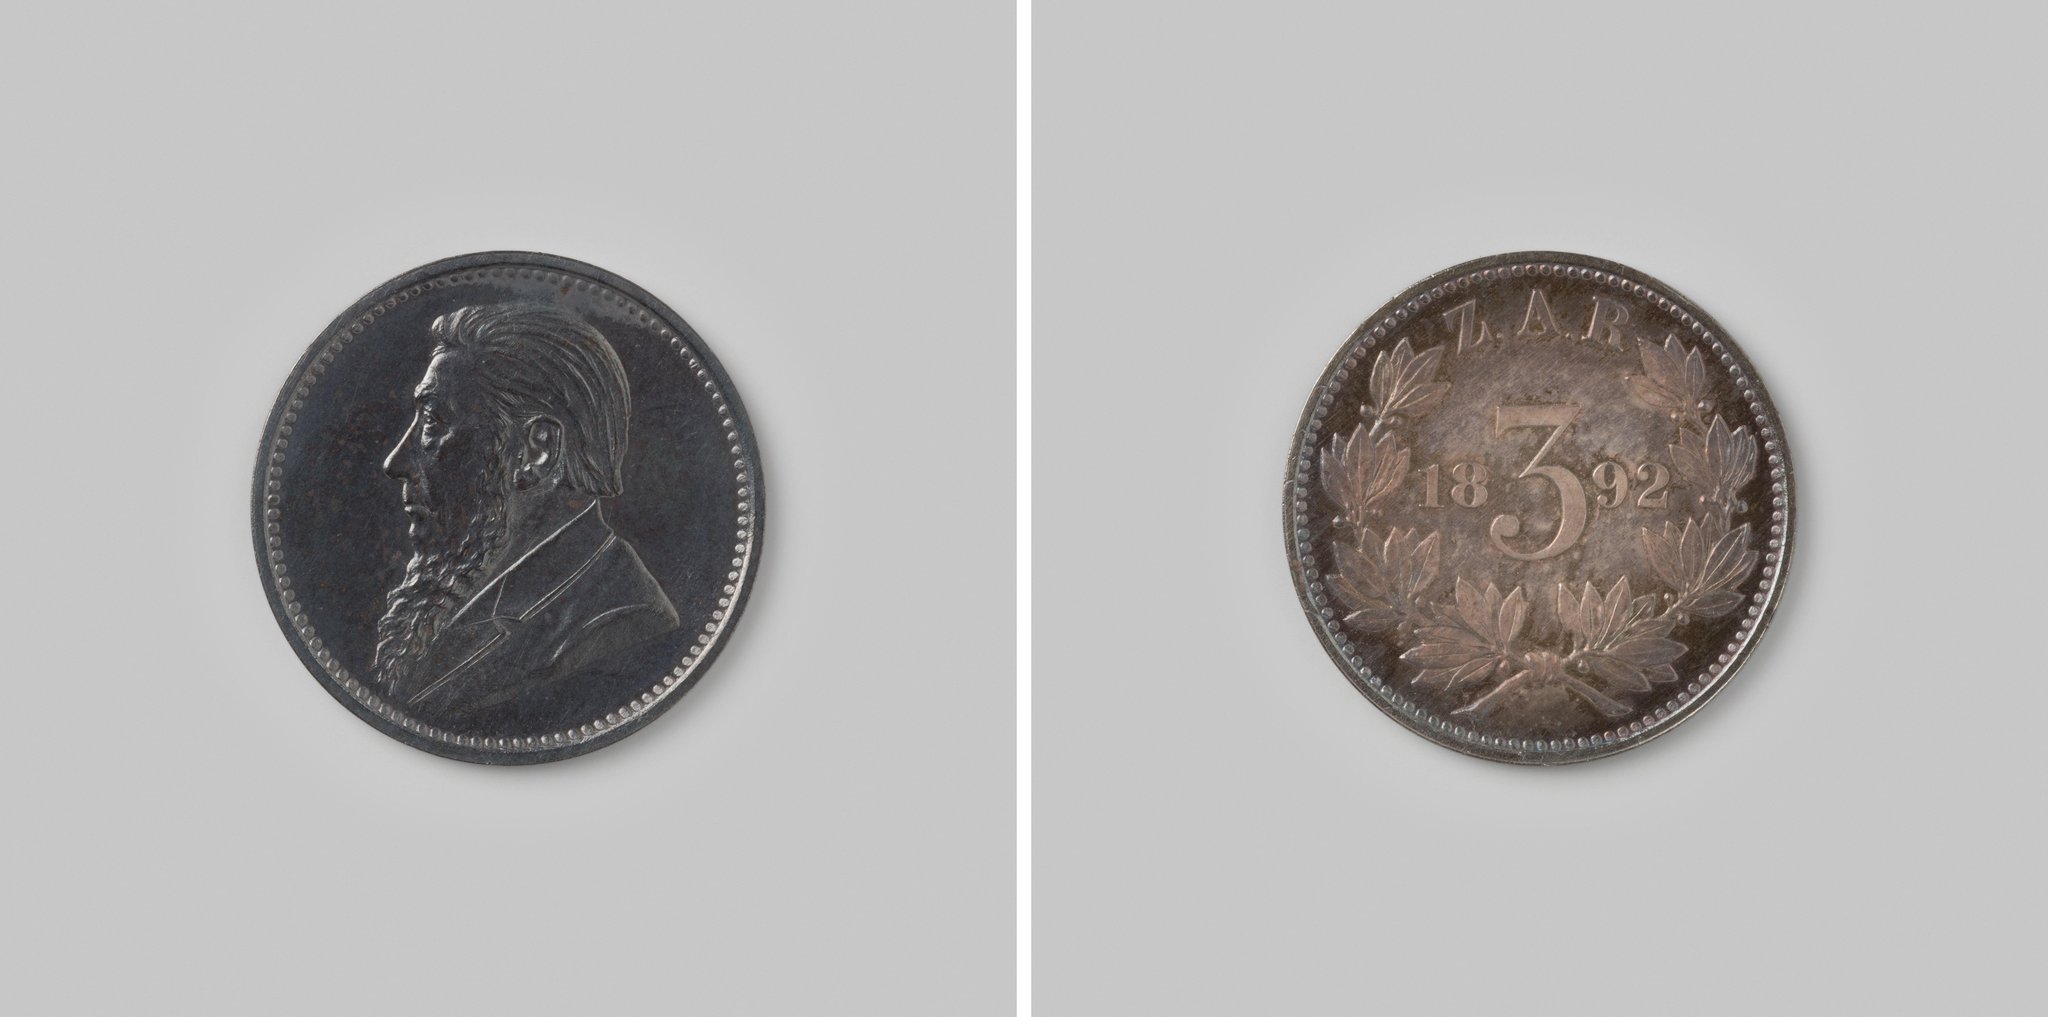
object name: coin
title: 3 pence van Zuid-Afrika, de Zuidafrikaansche Republiek (Z.A.R.), 1892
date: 1892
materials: silver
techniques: striking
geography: pretoria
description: Zilveren munt. Voorzijde: borstbeeld van president Krüger naar links. Keerzijde: binnen twee samengebonden takken waarde-aanduiding: 3 tussen jaartal. Bovenaan Z.A.R.